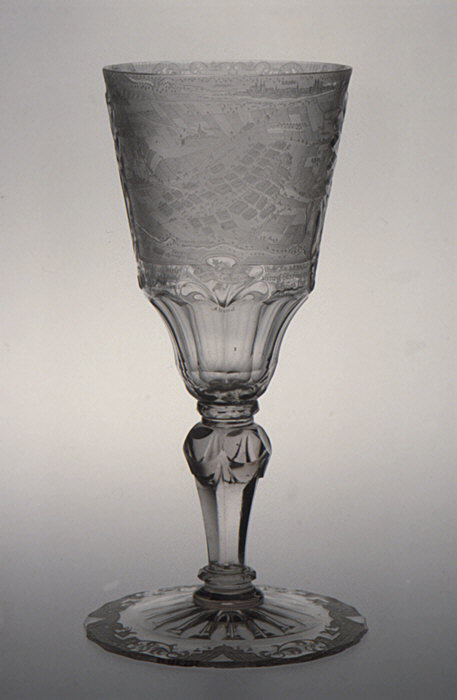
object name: standing cup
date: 1741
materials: glass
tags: men,coat of arms